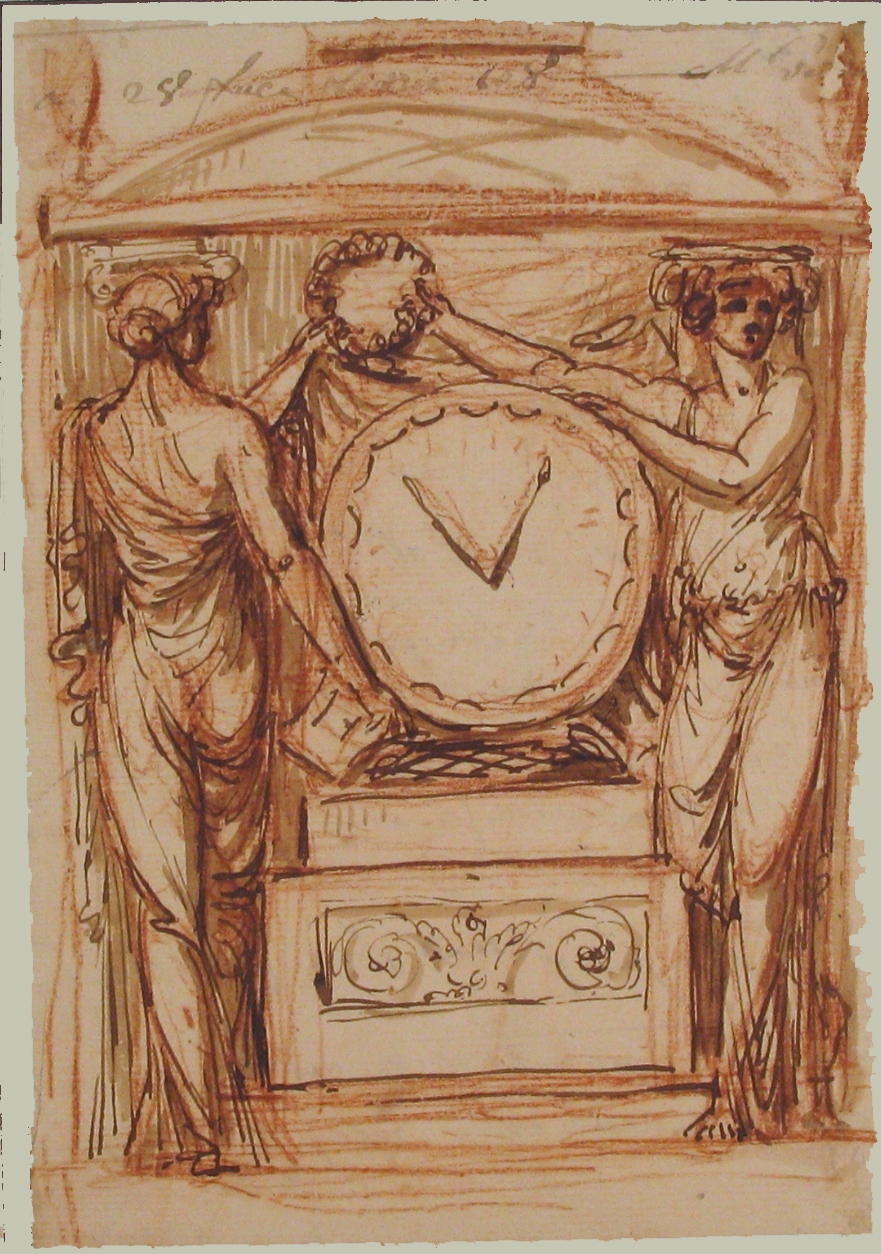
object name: drawing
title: Design for a Clock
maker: anonymous, french, 18th century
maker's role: artist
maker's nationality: french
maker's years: 1700-1800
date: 1701-1800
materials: chalk, ink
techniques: brush, pen, wash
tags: men,women,wreaths,clocks